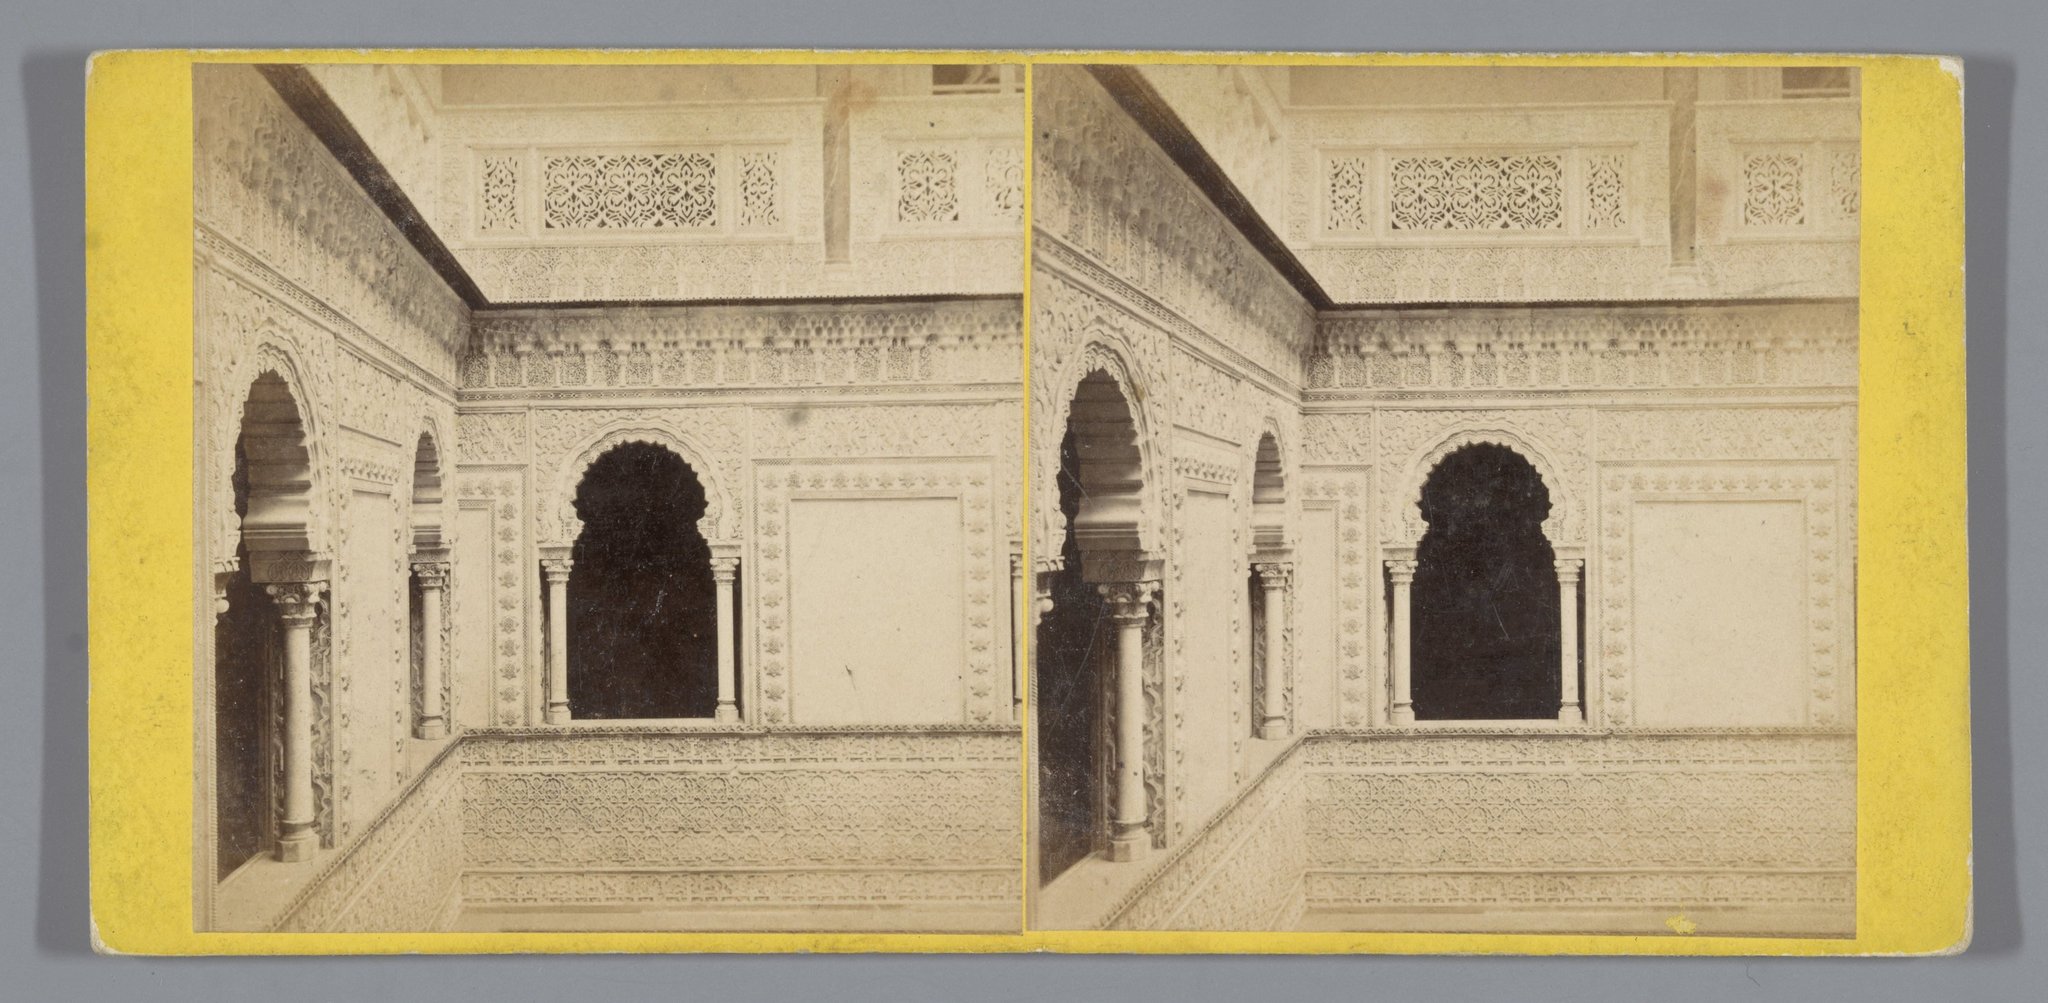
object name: stereograph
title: Gezicht op een venster in het Koninklijk Paleis te Sevilla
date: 1850-1880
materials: cardboard, photographic support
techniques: albumen print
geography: royal palace of seville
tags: window-seat, palace, façade (of house or building)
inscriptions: name: ‘Frank M. Good's Spain’, number: ‘No. 324.’